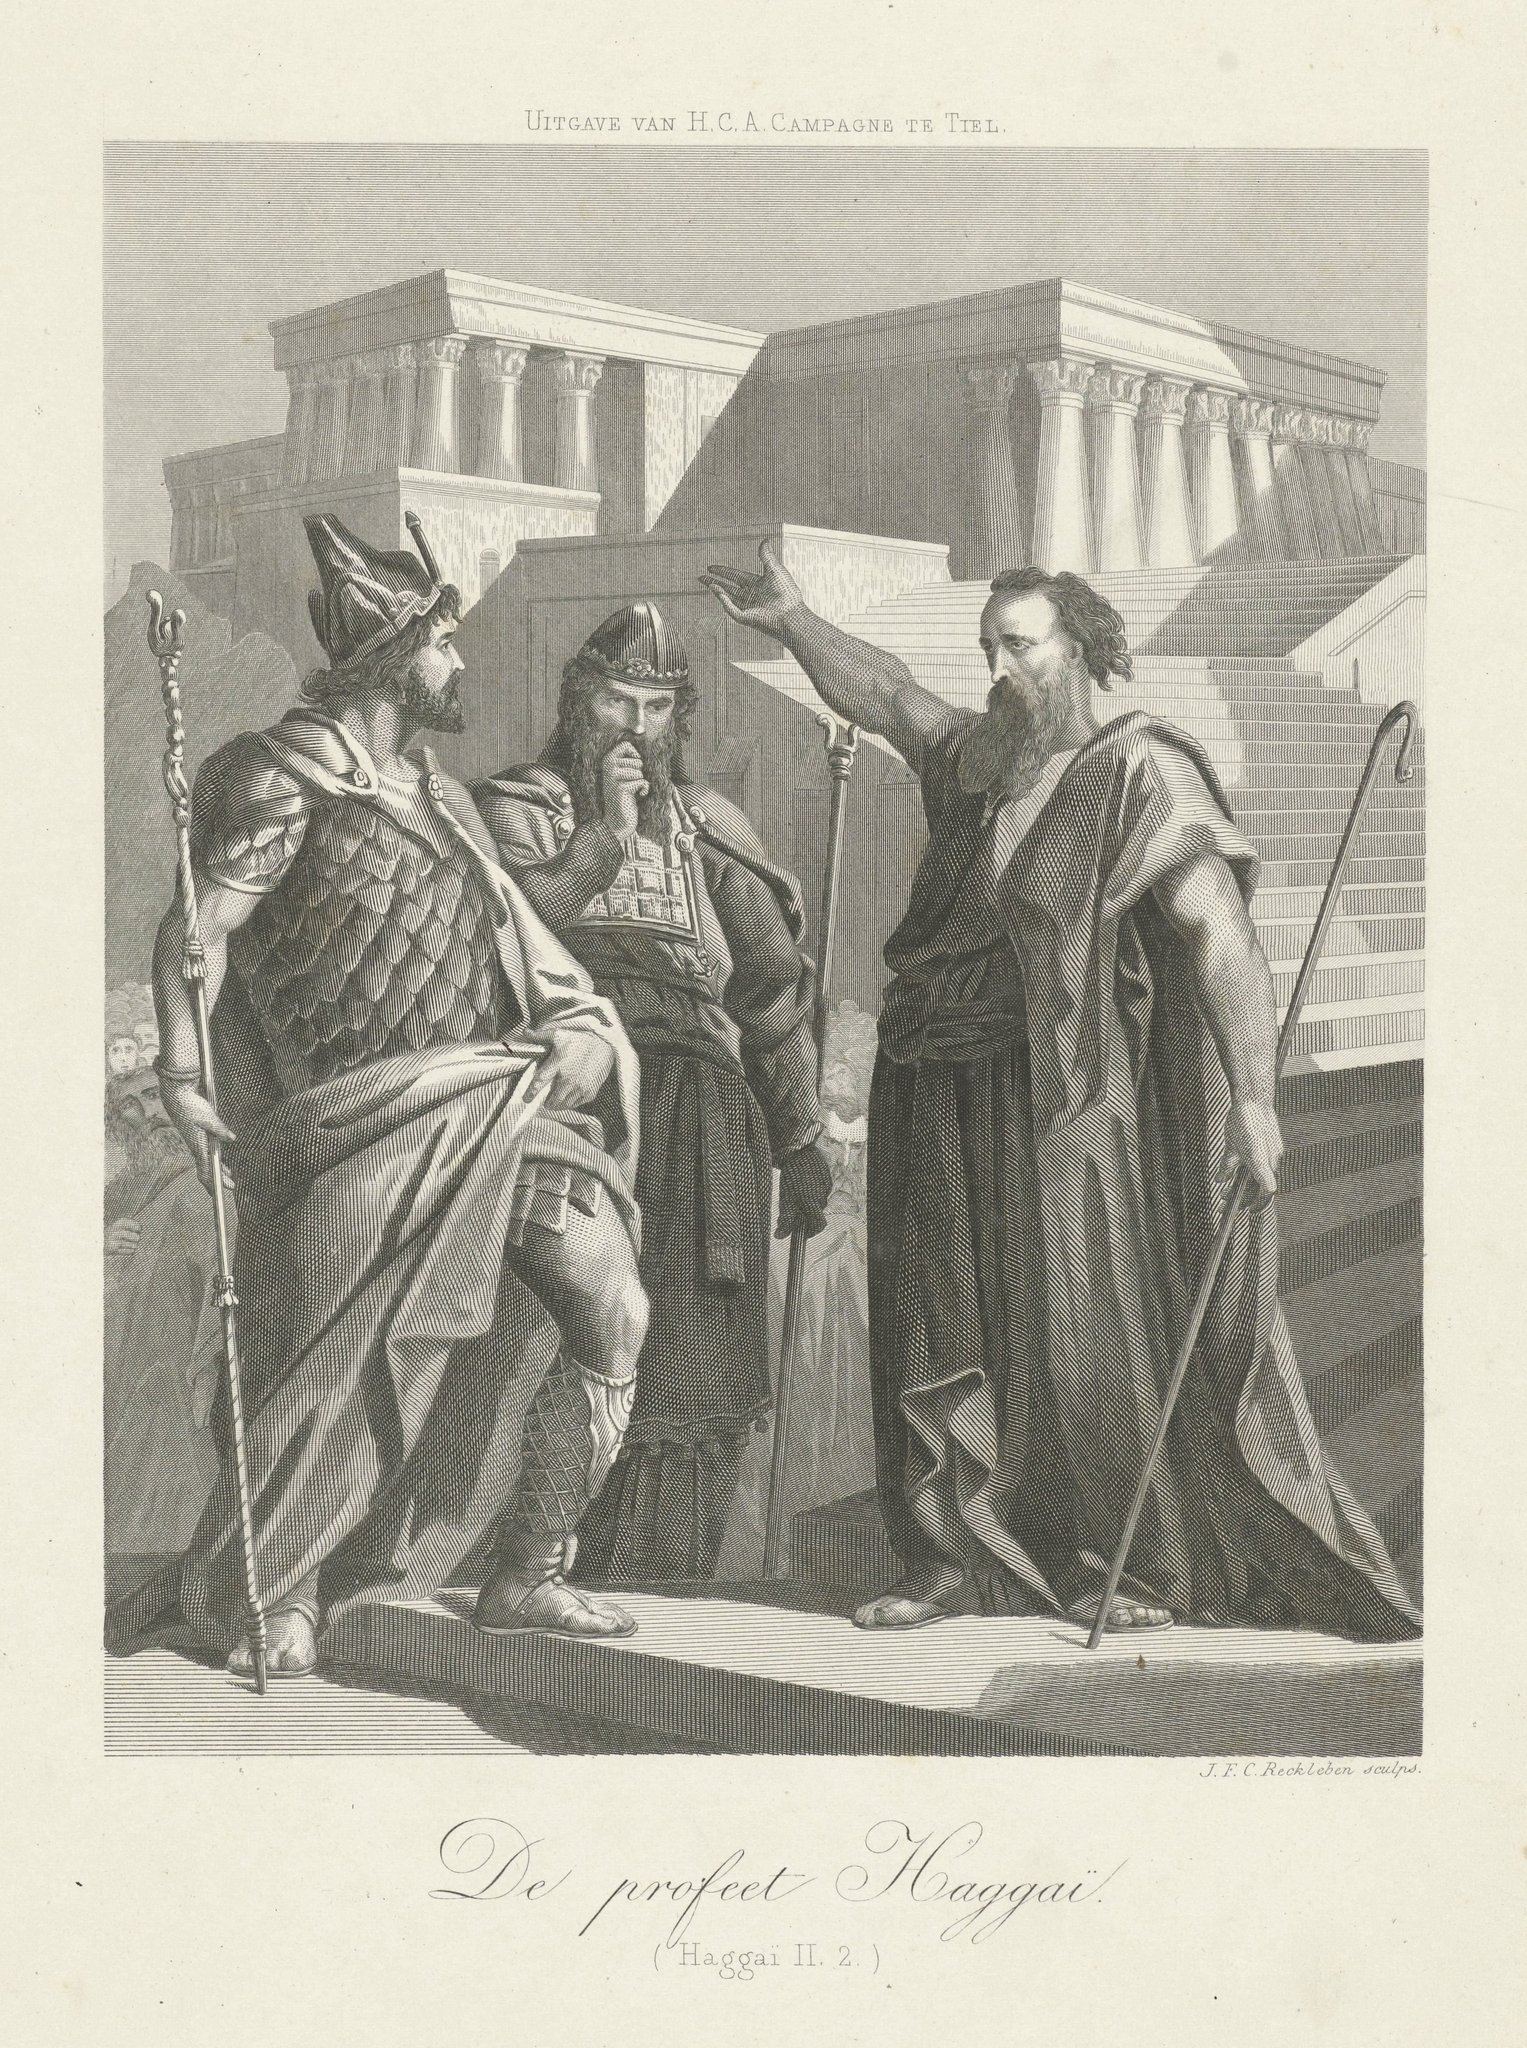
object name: print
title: De profeet Haggai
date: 1829-1879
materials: paper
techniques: engraving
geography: tiel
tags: exhorted by the prophets haggai and zechariah, zerubbabel and jeshua resume the rebuilding of the temple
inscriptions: collector's mark: Lugt 2228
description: De profeet Haggai roept gouverneur Zerubbabel en hogepriester Jozua op om aan het werk te gaan en te tempel herbouwen (Haggai 2:2).